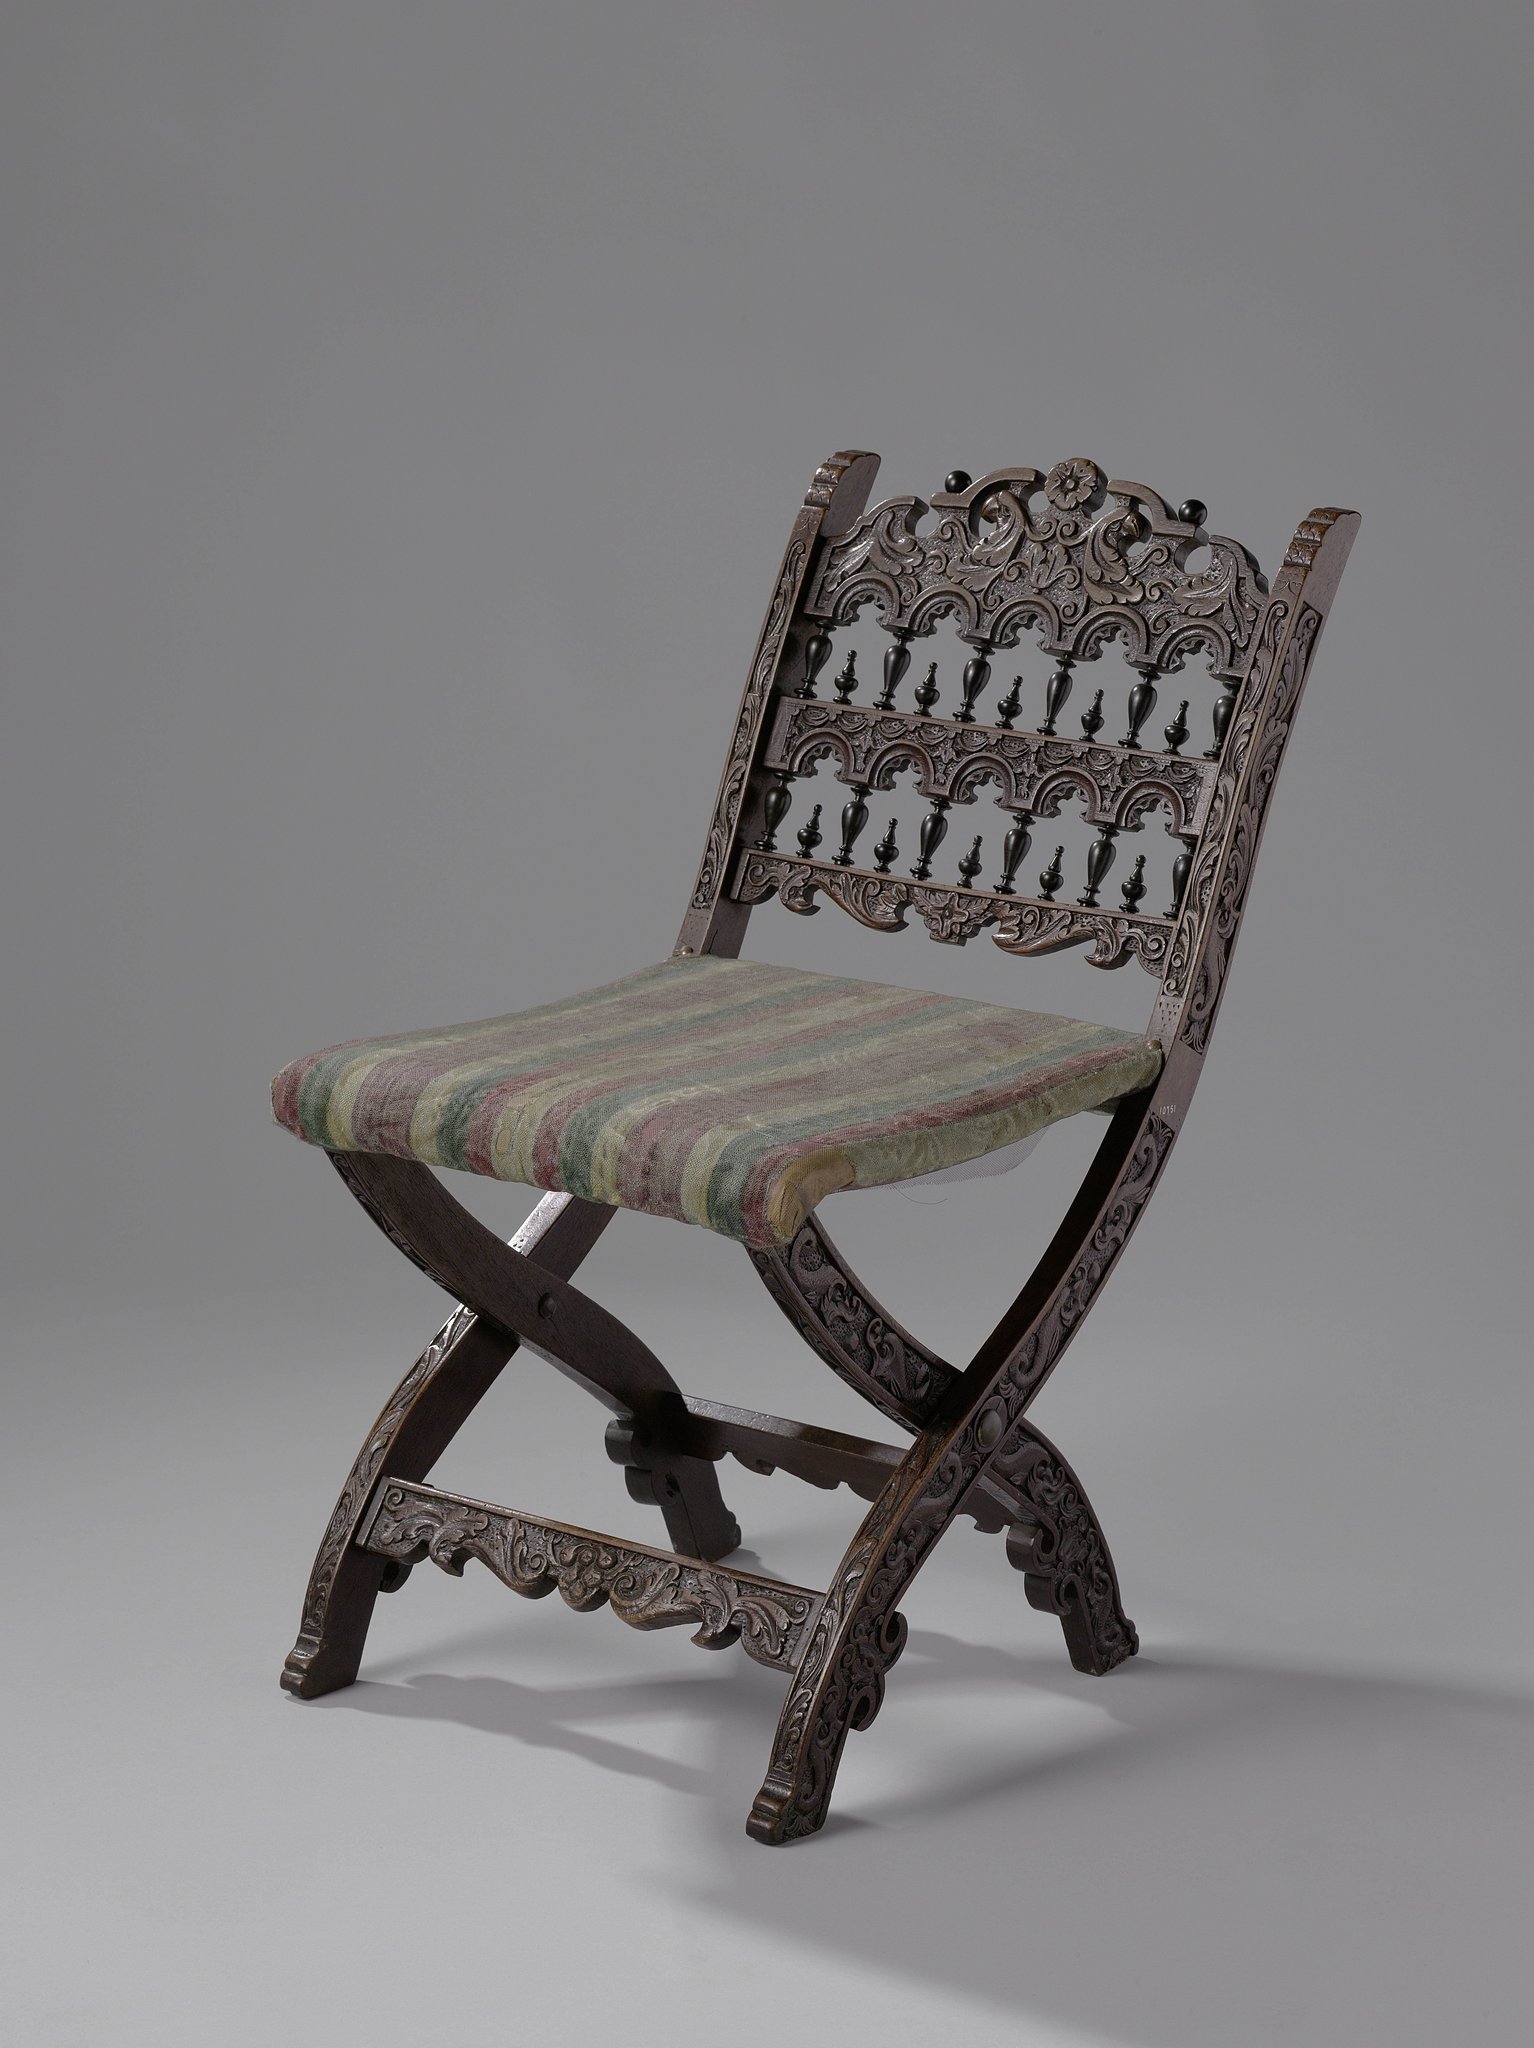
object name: furniture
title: Kerkstoel van notenhout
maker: Anonymous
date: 1640-1660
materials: wood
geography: northern netherlands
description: Kerkstoel van notenhout. Het stoeltje is opvouwbaar, heeft een beklede zitting en rust op schragen. De schragen zijn gestrekt S-vormig, door pinnen met koperen doppen verbonden. De rug heeft drie sporten; de middelste en bovenste sport hebben aan de onderkanten vijf bogen, die op gedraaide ebbenhouten balusters rusten. Tussen de balusters bevinden zich ebbenhouten vaasjes. De bovenste sport wordt bekroond door twee ebbenhouten ballen en is versierd met hanekoppen, een rozet en een acanthusblad.